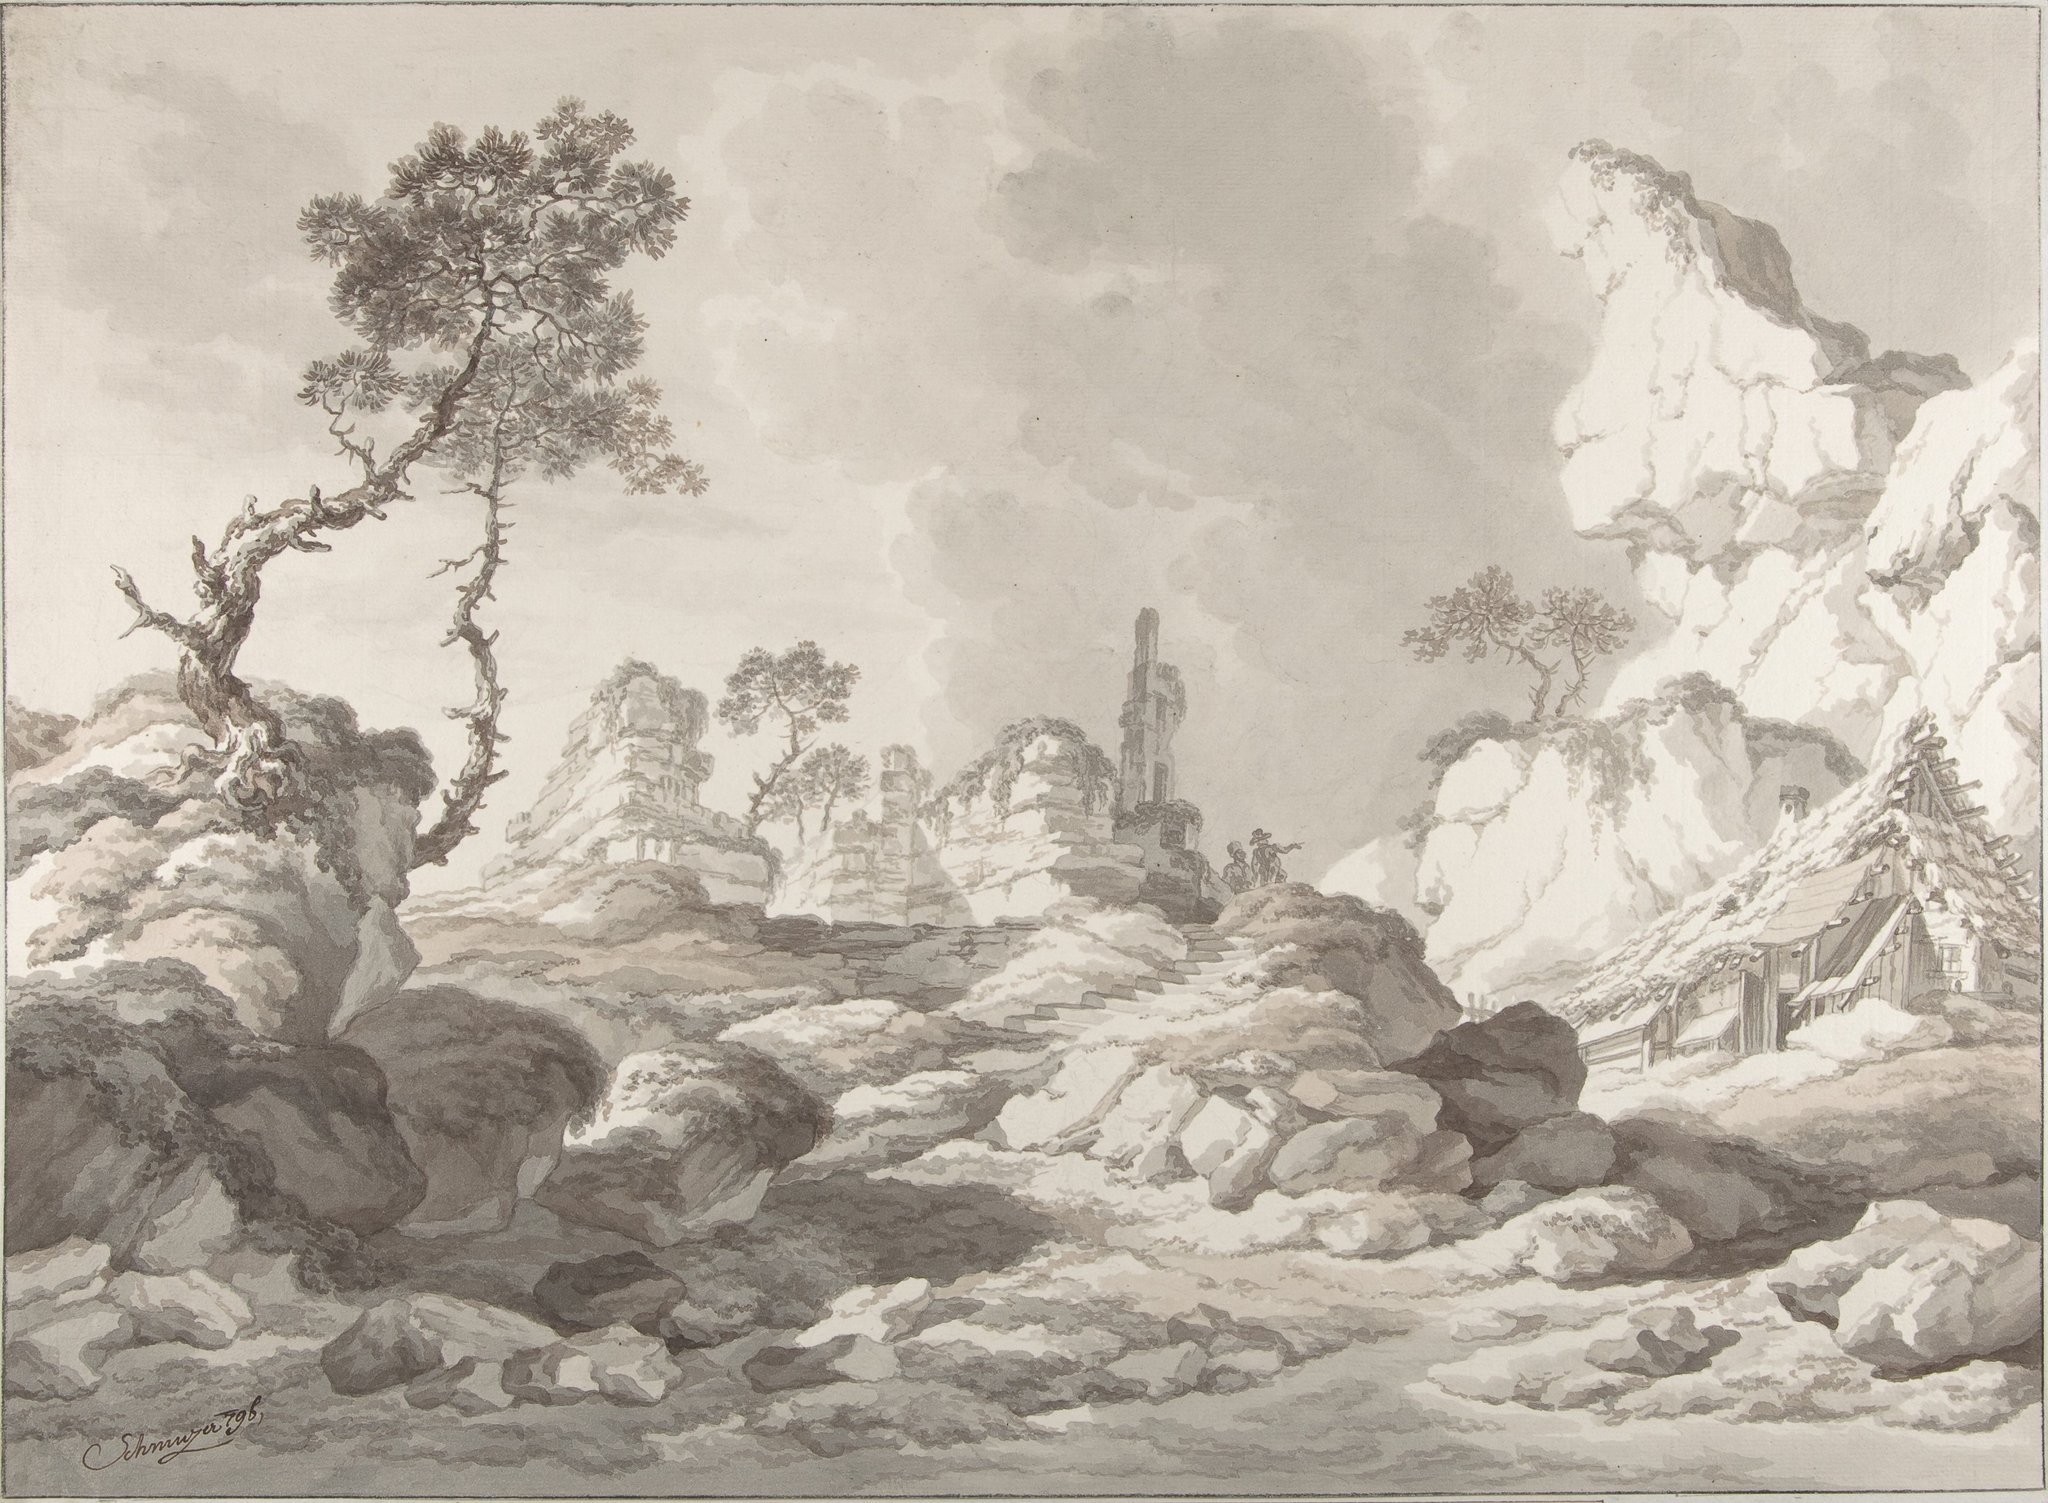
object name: drawing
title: Landscape with a ruin near Mödling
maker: jakob matthias schmutzer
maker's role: artist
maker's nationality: austrian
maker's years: 1733-1811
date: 1796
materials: chalk, ink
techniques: brush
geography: austria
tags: houses,ruins,landscapes,trees